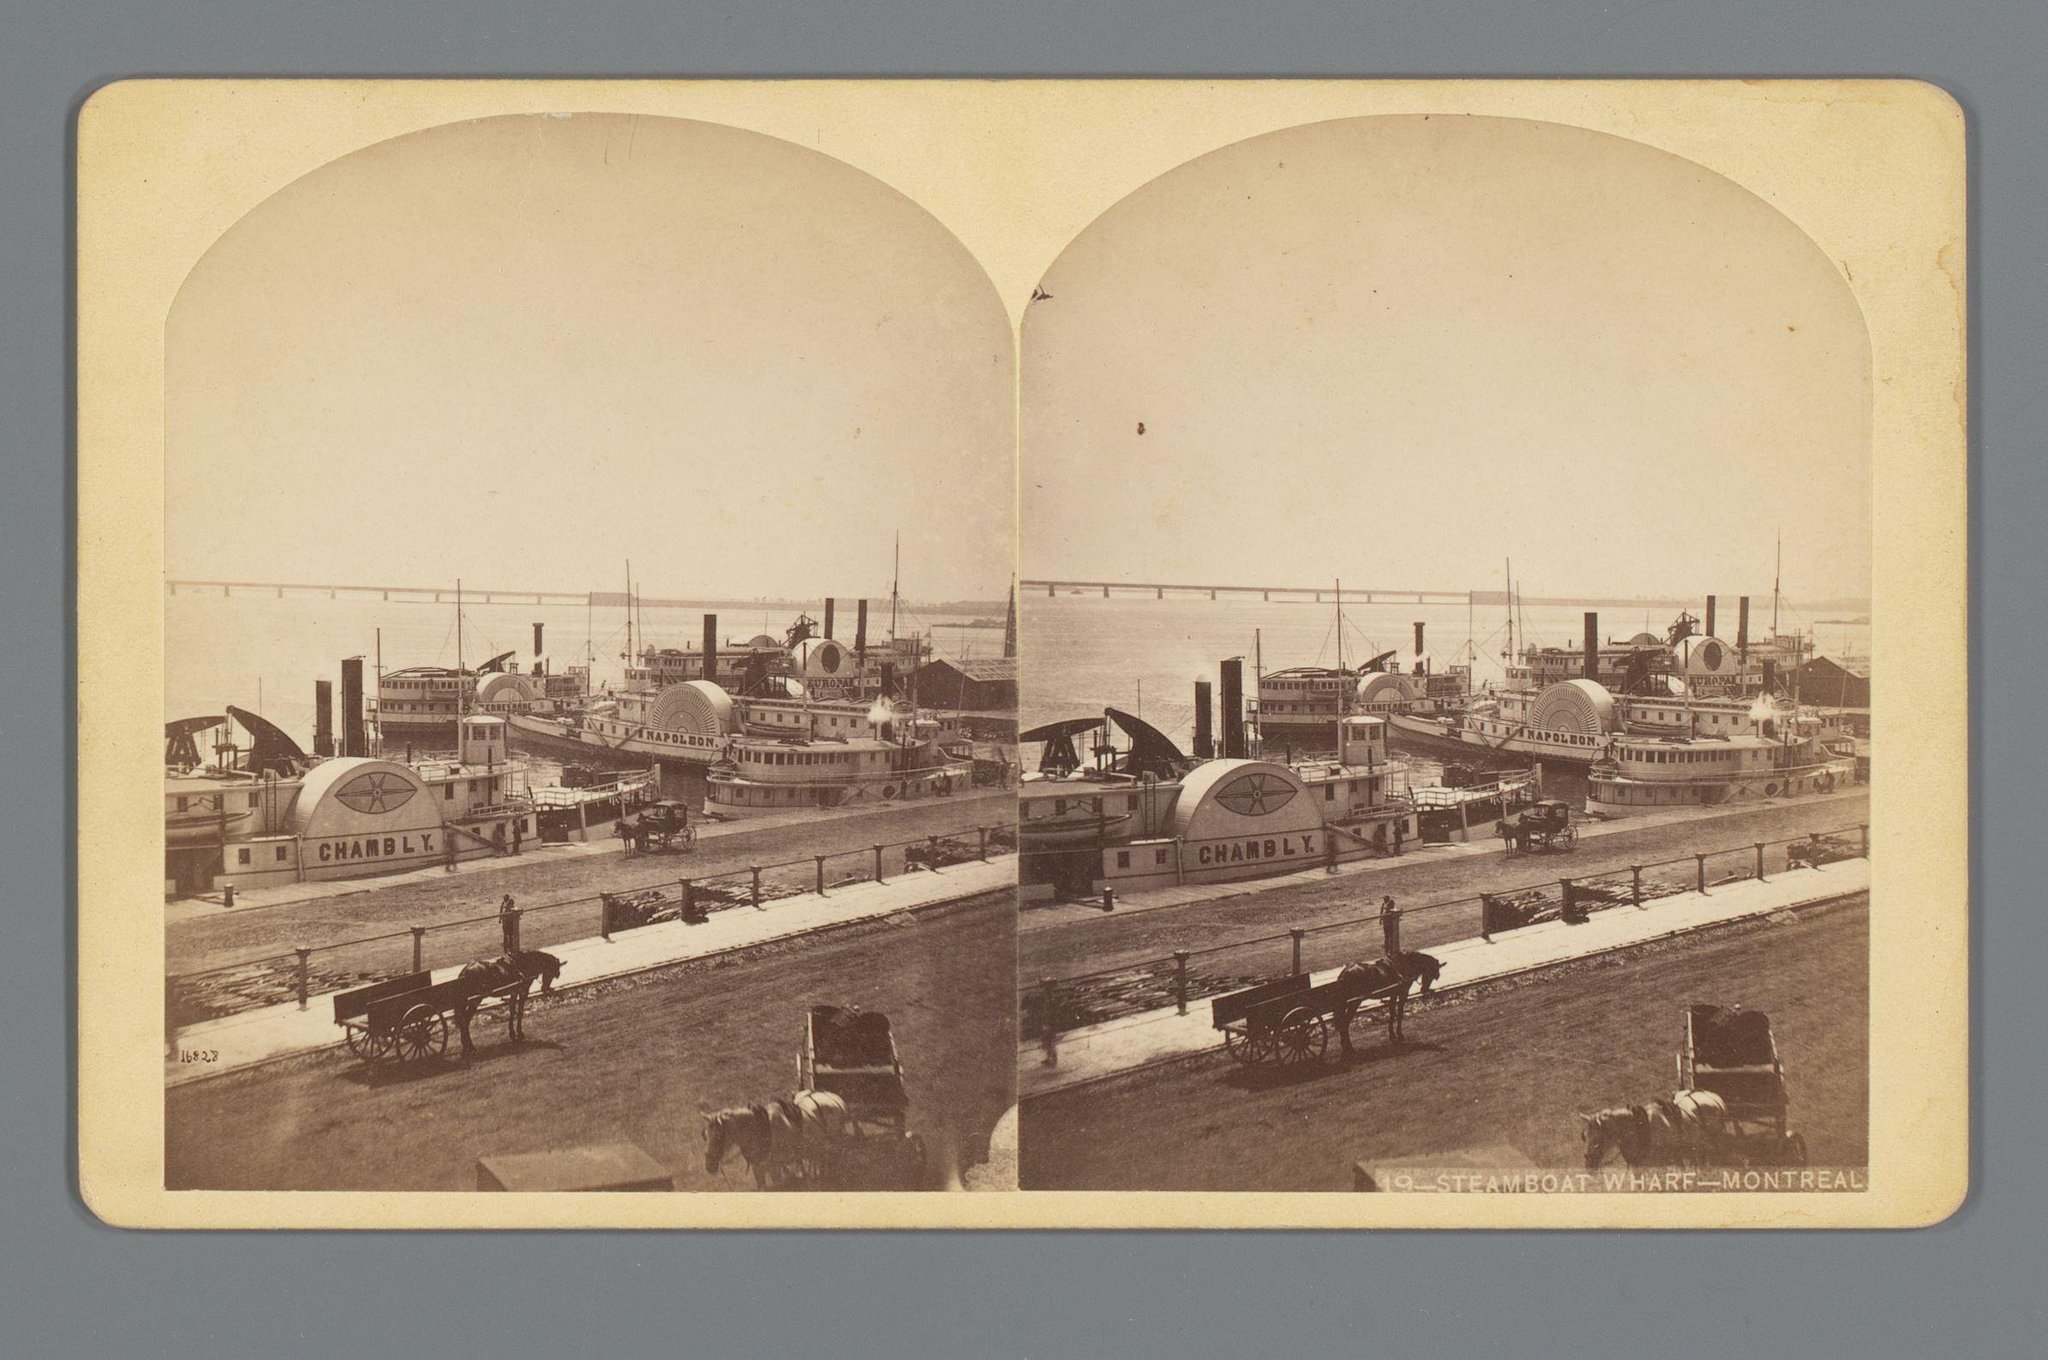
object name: stereograph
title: Stoomboten in Montréal, Canada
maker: william notman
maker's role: fotograaf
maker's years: 1826-1891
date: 1867-1870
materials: cardboard, paper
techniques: albumen print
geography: montreal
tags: harbour, pier, quay, wharf, steamship, motorship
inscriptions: number: ‘19’, inscription: ‘W. NOTMAN/ (...)/ MONTREAL./ Branches at/ Toronto and Halifax.’